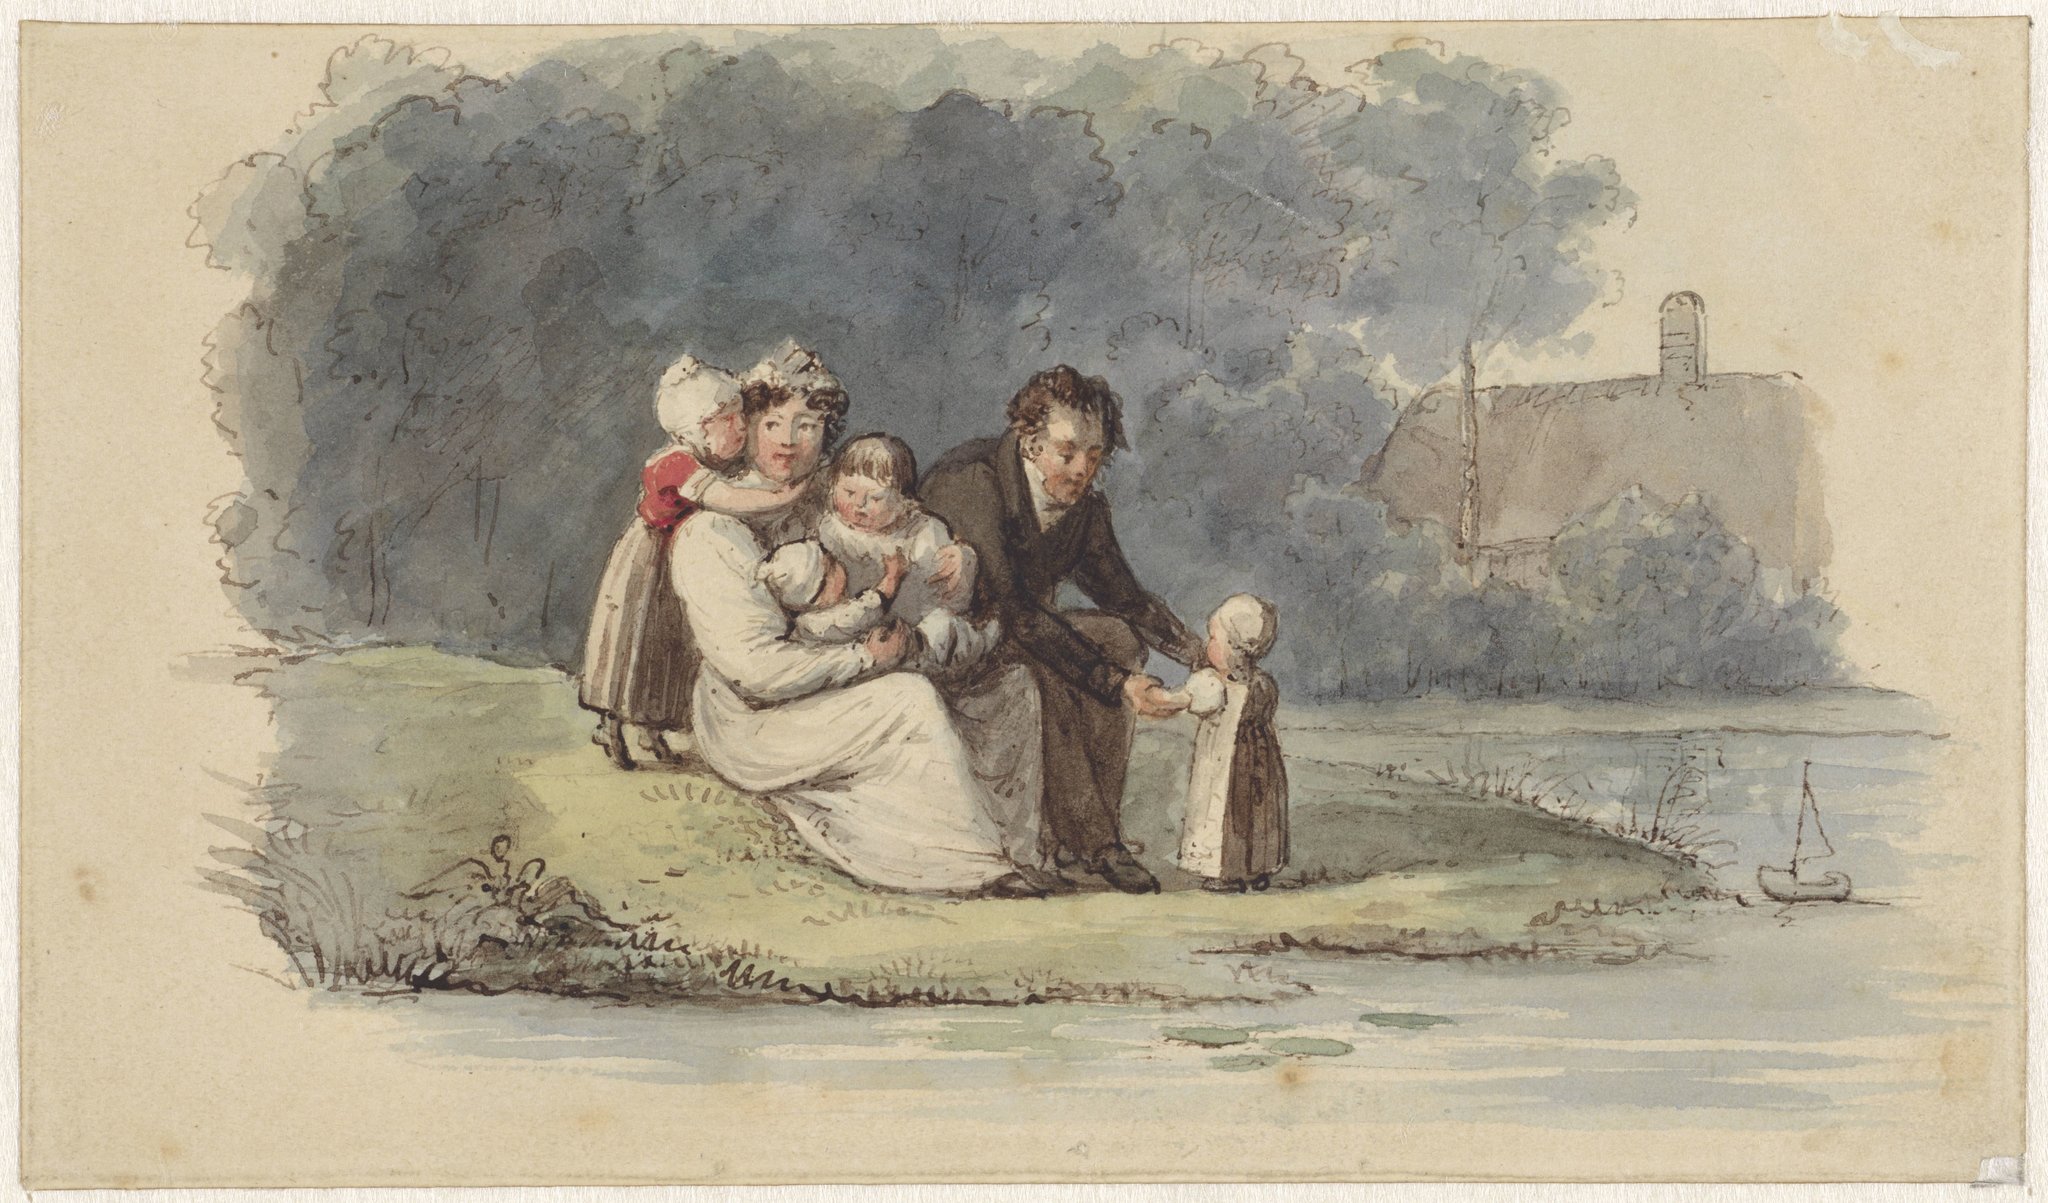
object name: drawing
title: Familie zittend aan het water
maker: christiaan julius lodewijk portman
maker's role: draughtsman, painter, print maker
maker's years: 1799-1868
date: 1828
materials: ink, paper, watercolor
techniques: brush, pen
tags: lake, family life